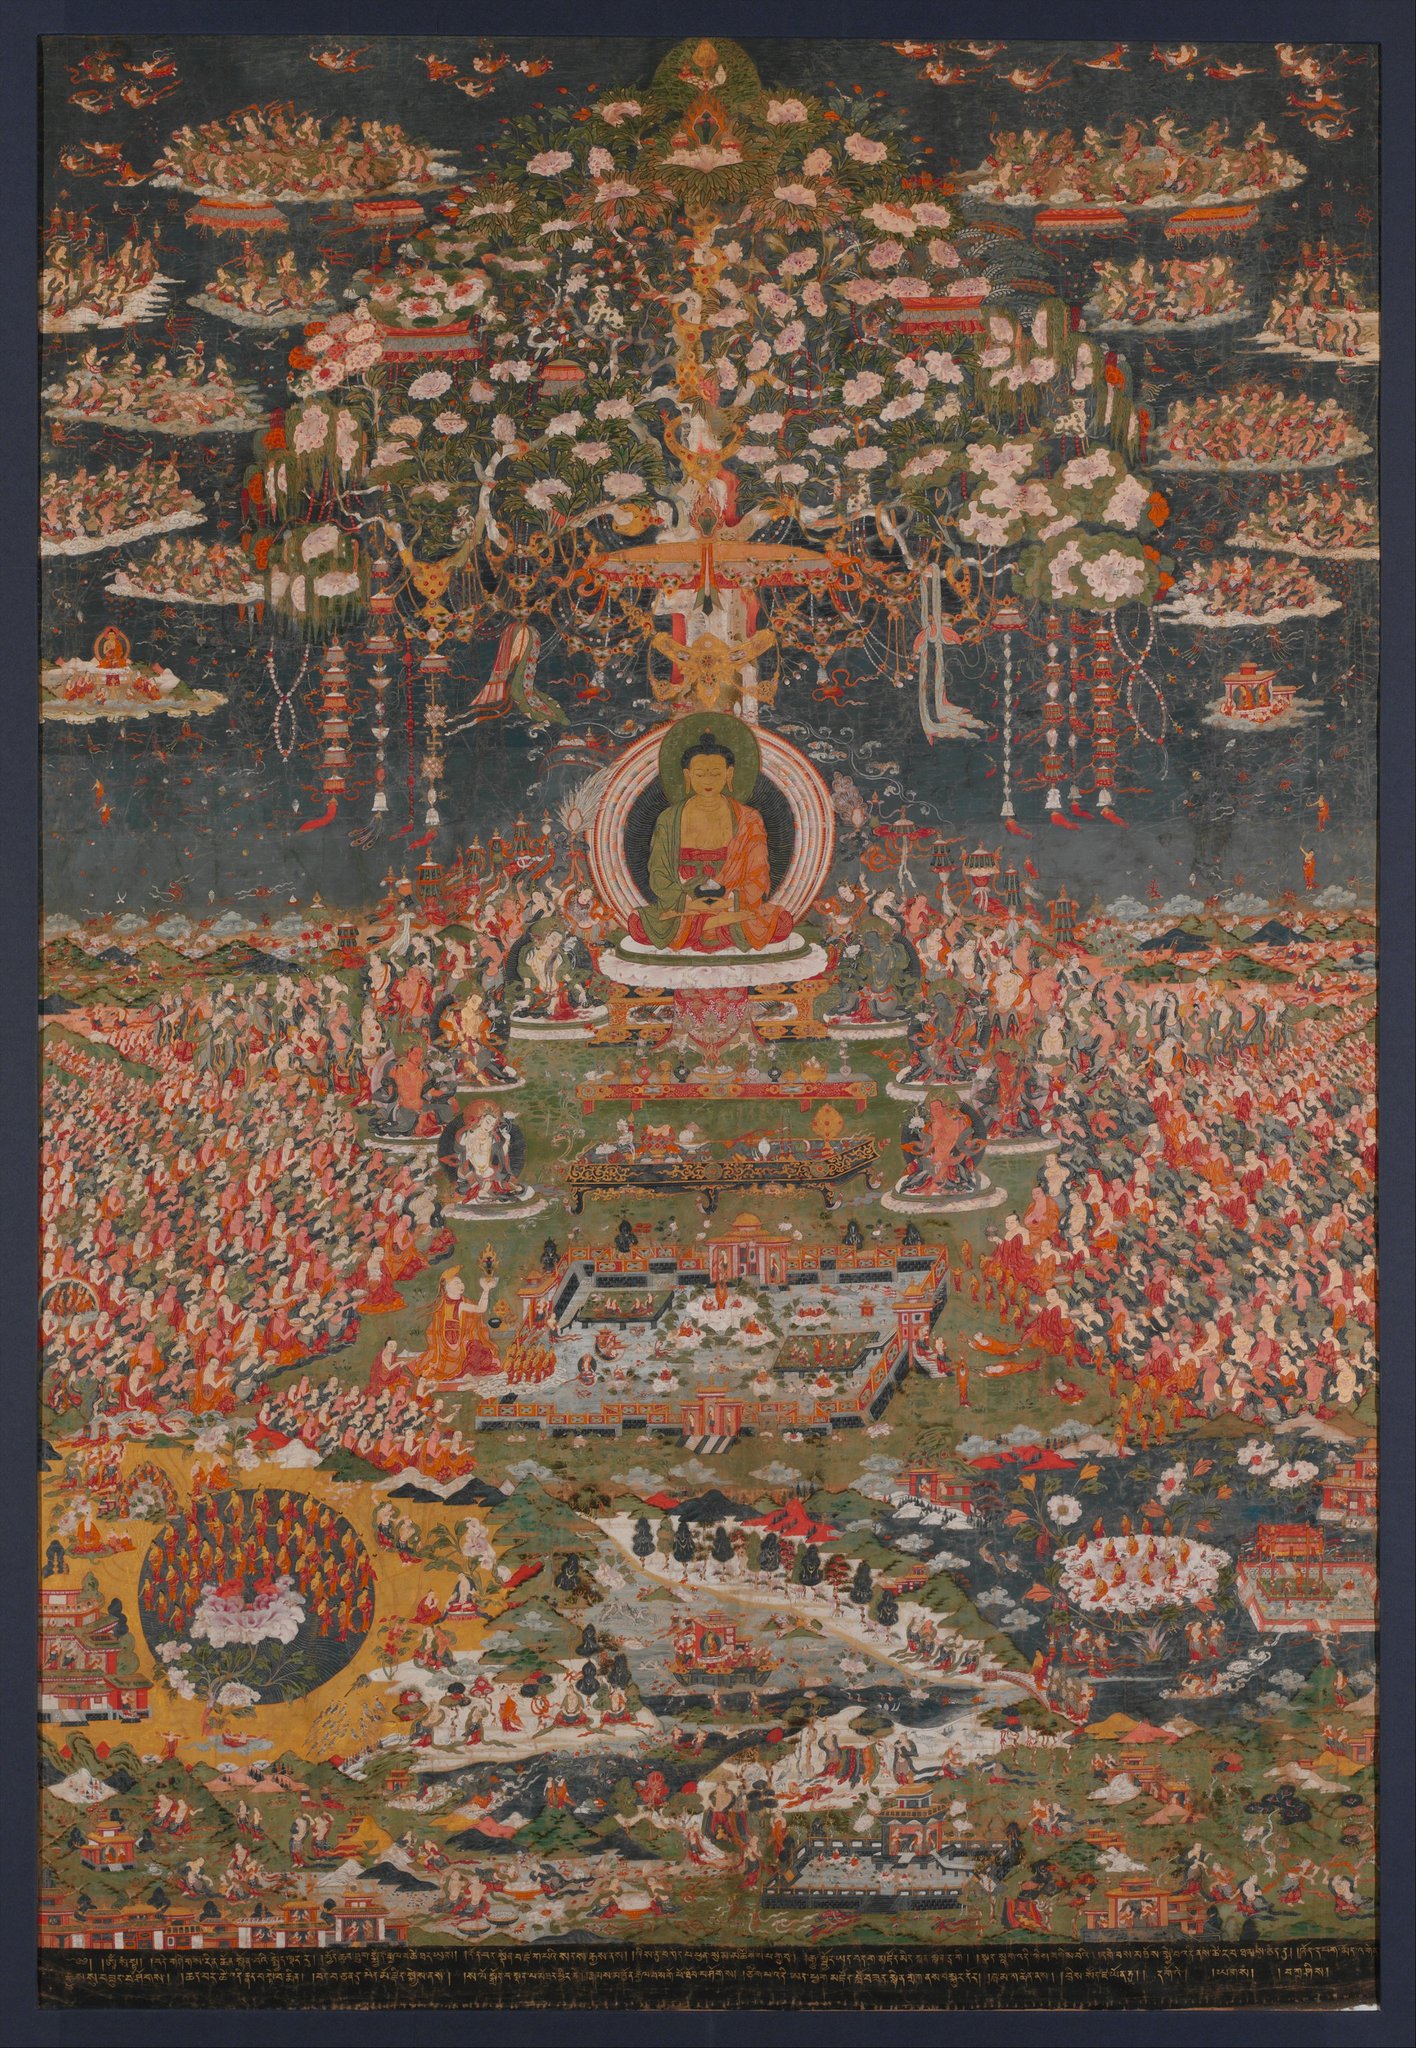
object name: thangka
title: Amitabha, the Buddha of the Western Pure Land (Sukhavati)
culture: tibetan, central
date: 1700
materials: textile, gold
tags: buddhism,bodhisattvas,buddha,crowd